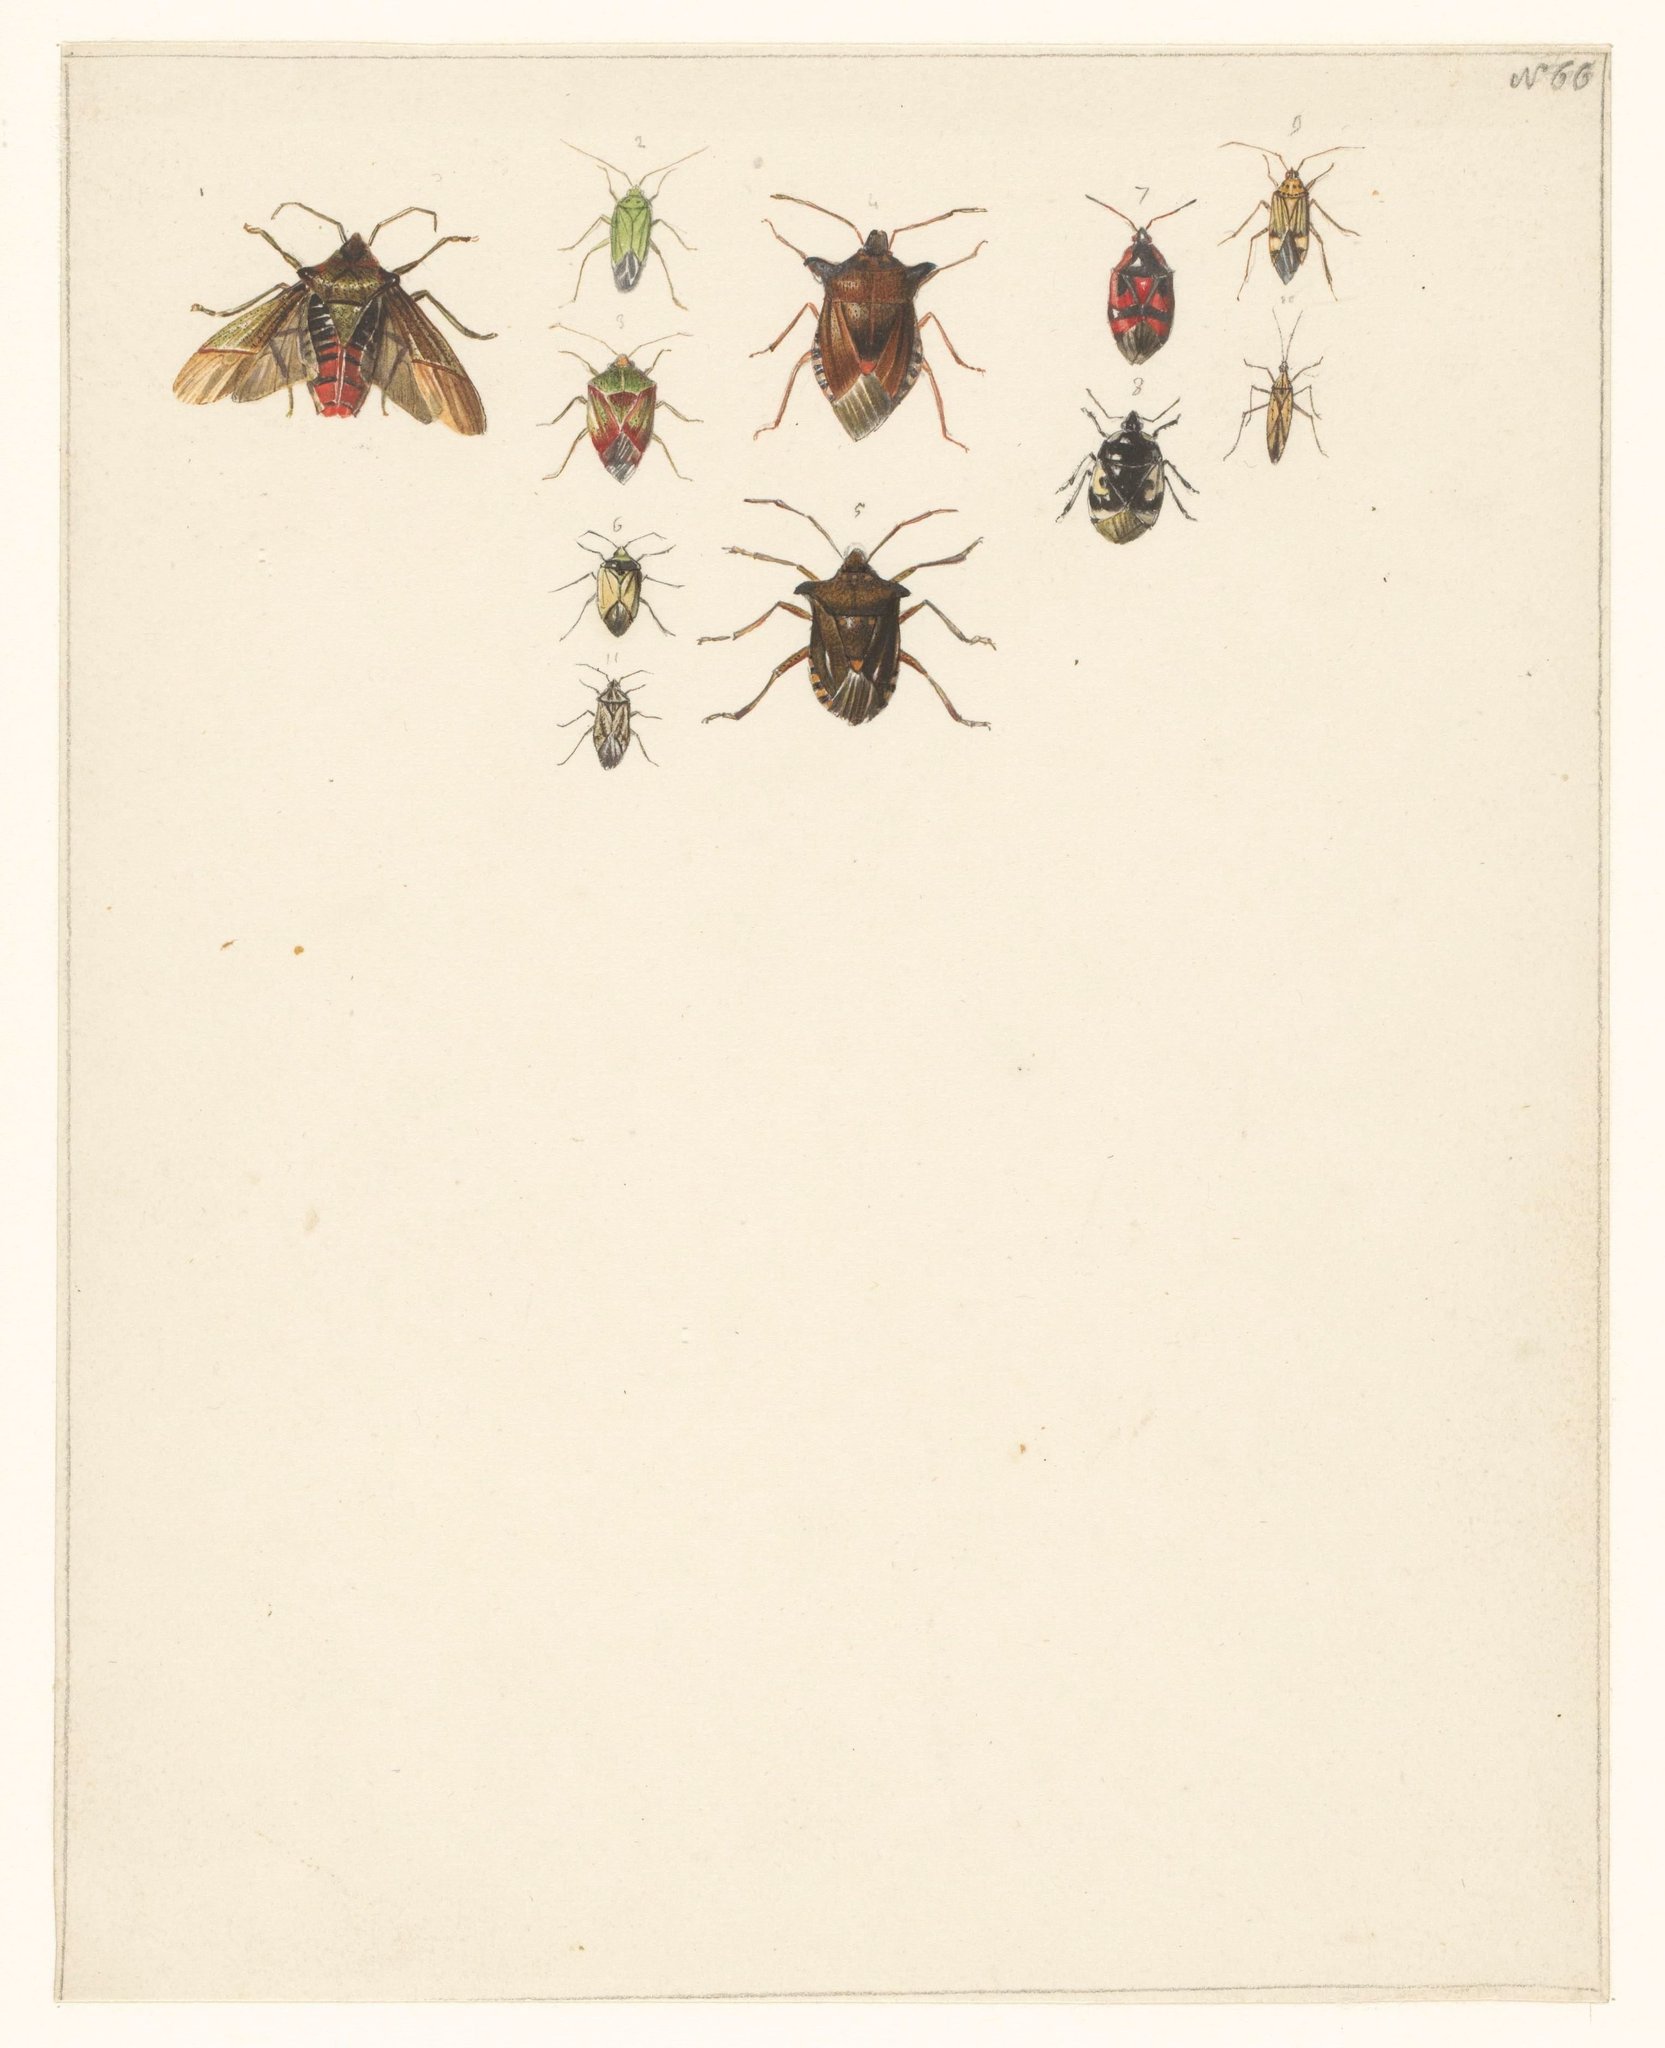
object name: drawing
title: Studieblad met elf verschillende kevers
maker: albertus steenbergen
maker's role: draughtsman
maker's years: 1814-1900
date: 1824-1900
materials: ink, paper, pencil, watercolor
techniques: brush, pen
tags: insects: beetle